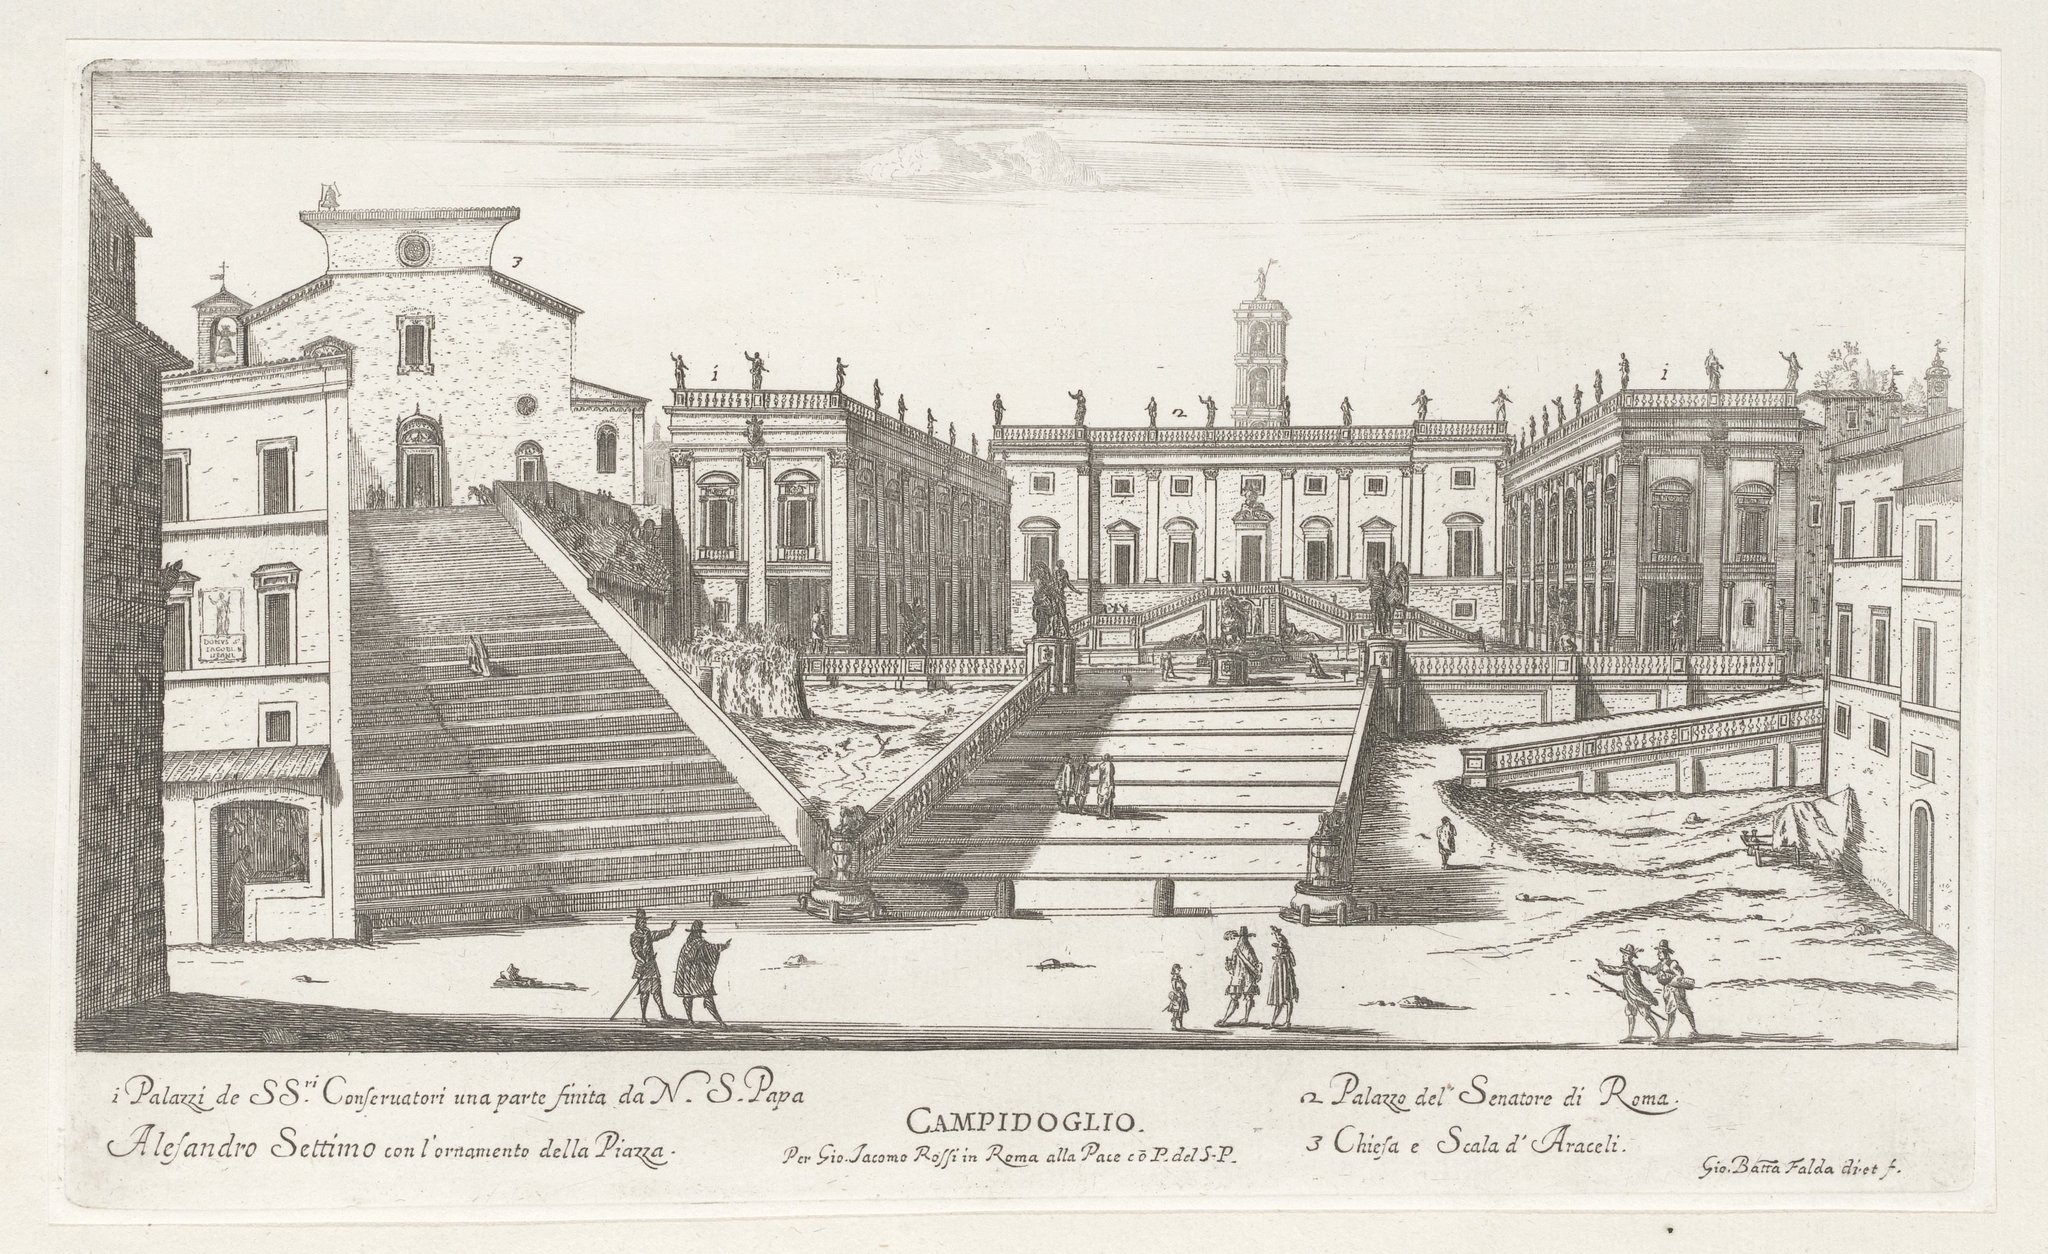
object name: album leaf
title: Magesyn der Italiaense gebouwen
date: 1665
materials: paper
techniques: etching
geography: rome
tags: city-view, and landscape with man-made constructions, church (exterior), roman catholic church, street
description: Deze prent maakt deel uit van een reeks bestaande uit vijf delen, waarvan de eerste drie delen bestaan uit prenten van Giovanni Battista Falda. Deel één bevat 25 prenten (+ titelprent en opdracht) (1665), deel twee bevat 15 prenten (+ titelprent en opdracht) (1665-67) en deel drie bevat 38 prenten (+ titelprent en opdracht) (1669-70). Delen vier en vijf bevatten prenten door Alessandro Specchi en Giovanni Domenico Campiglia. De originele drukplaten voor de eerste drie delen worden bewaard in de Calcografia Nazionale in Rome (inv. nr. 1414).